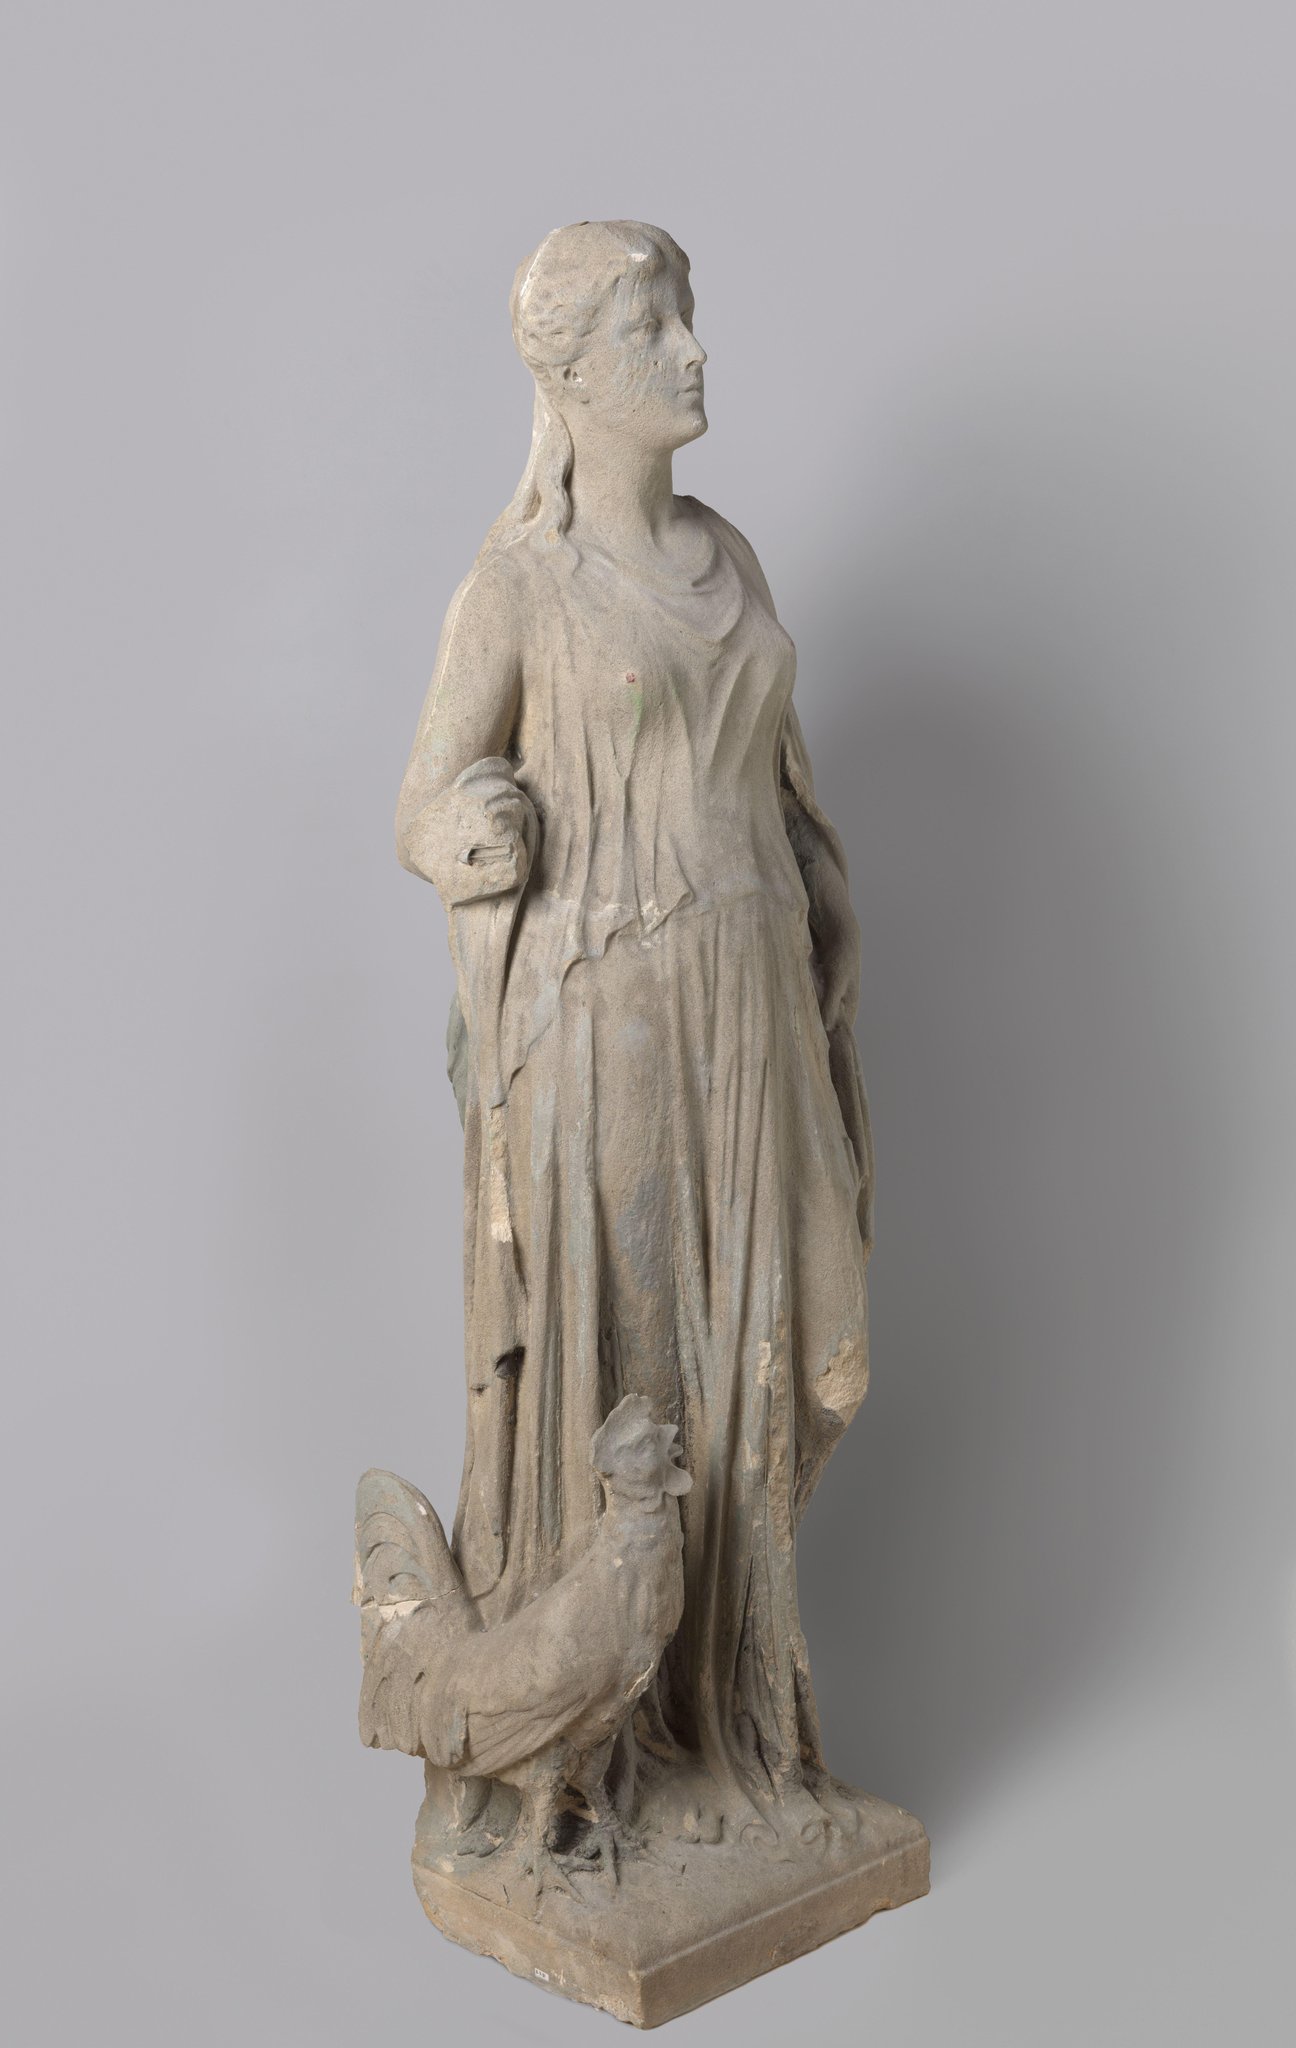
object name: sculpture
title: Staande vrouwenfiguur met tegen haar rechtervoet een haan; afkomstig uit de gevel van de villa van het Rijksmuseum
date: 1900-1925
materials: stone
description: Vrouw ten voeten uit staande met in haar linkerhand een plooi van haar lange gewaad. Tegen haar rechtervoet een staande haan. Bij het beeld hoort een beeld met invnr. BK-TN-3167. Bij beide beelden hoort een sokkel met invnr. BK-TN-3047 en BK-TN-3048.